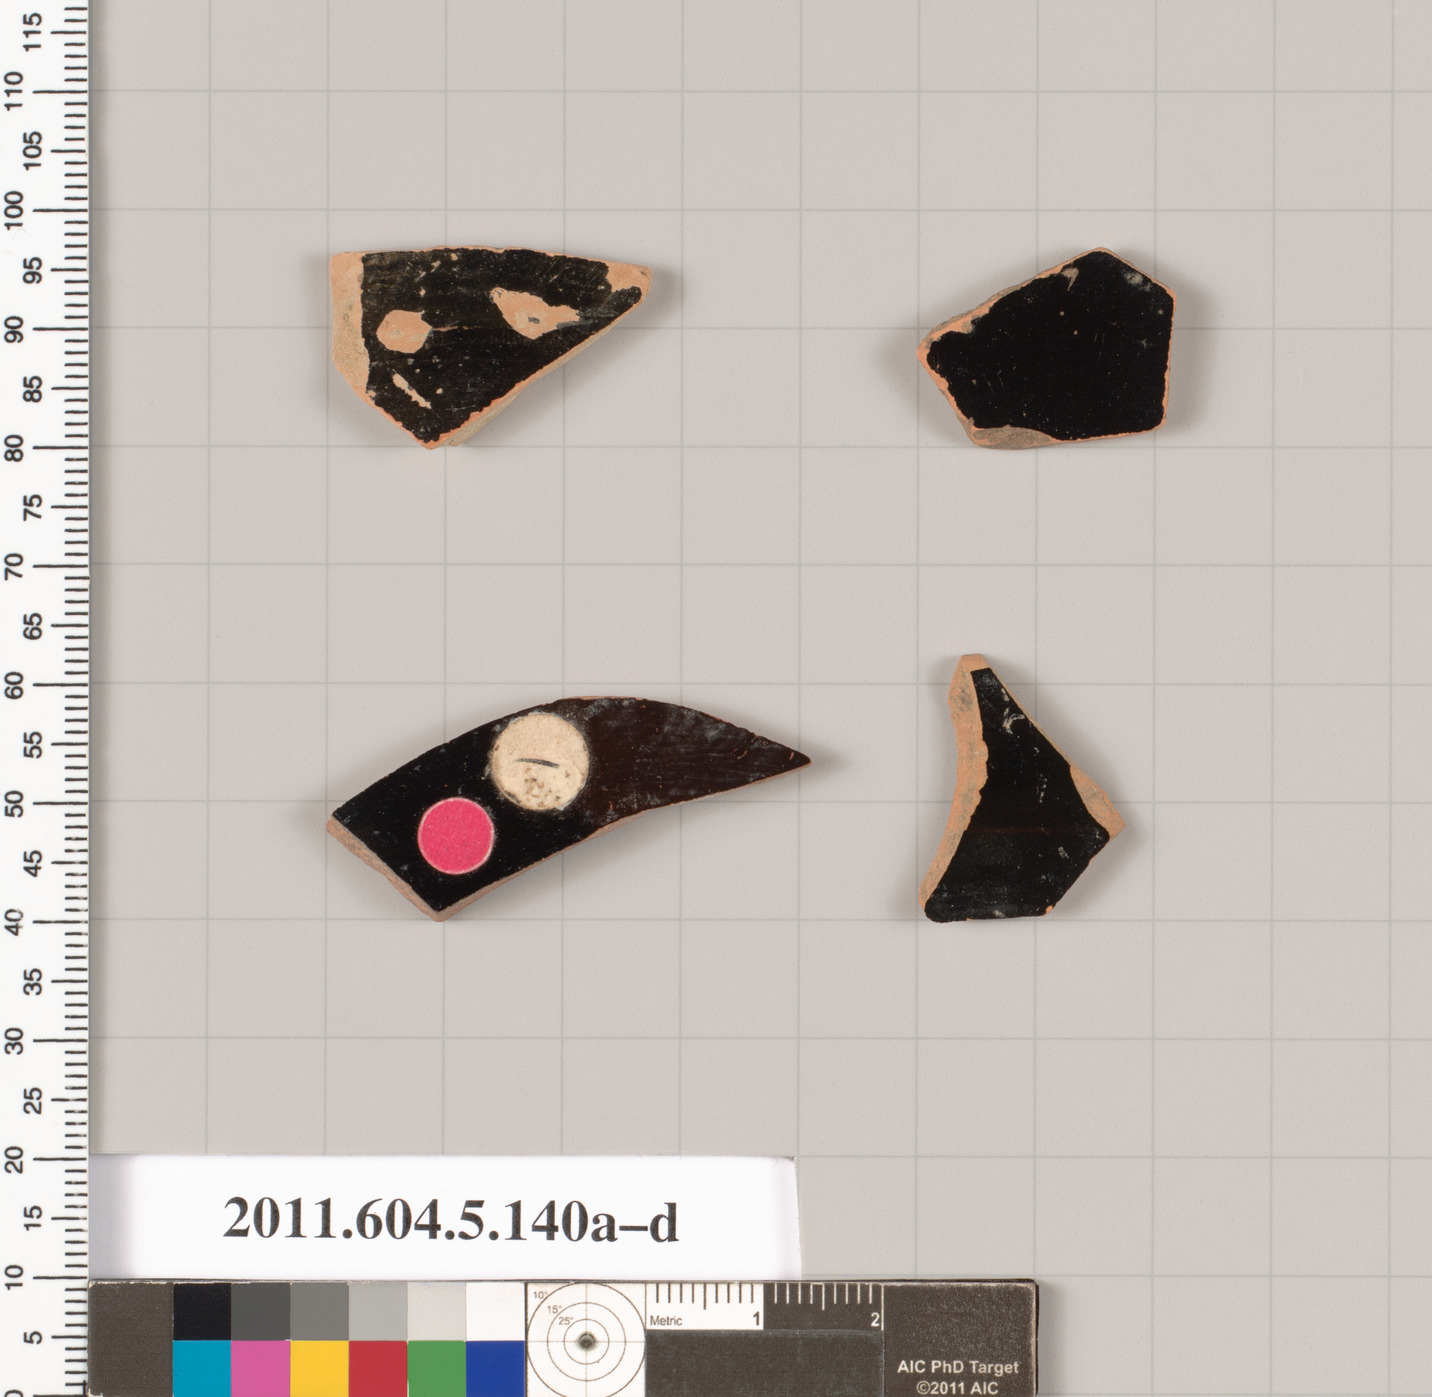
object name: kylix fragment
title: Terracotta fragments of kylikes (drinking cups)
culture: greek, attic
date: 600-401 BCE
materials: terracotta